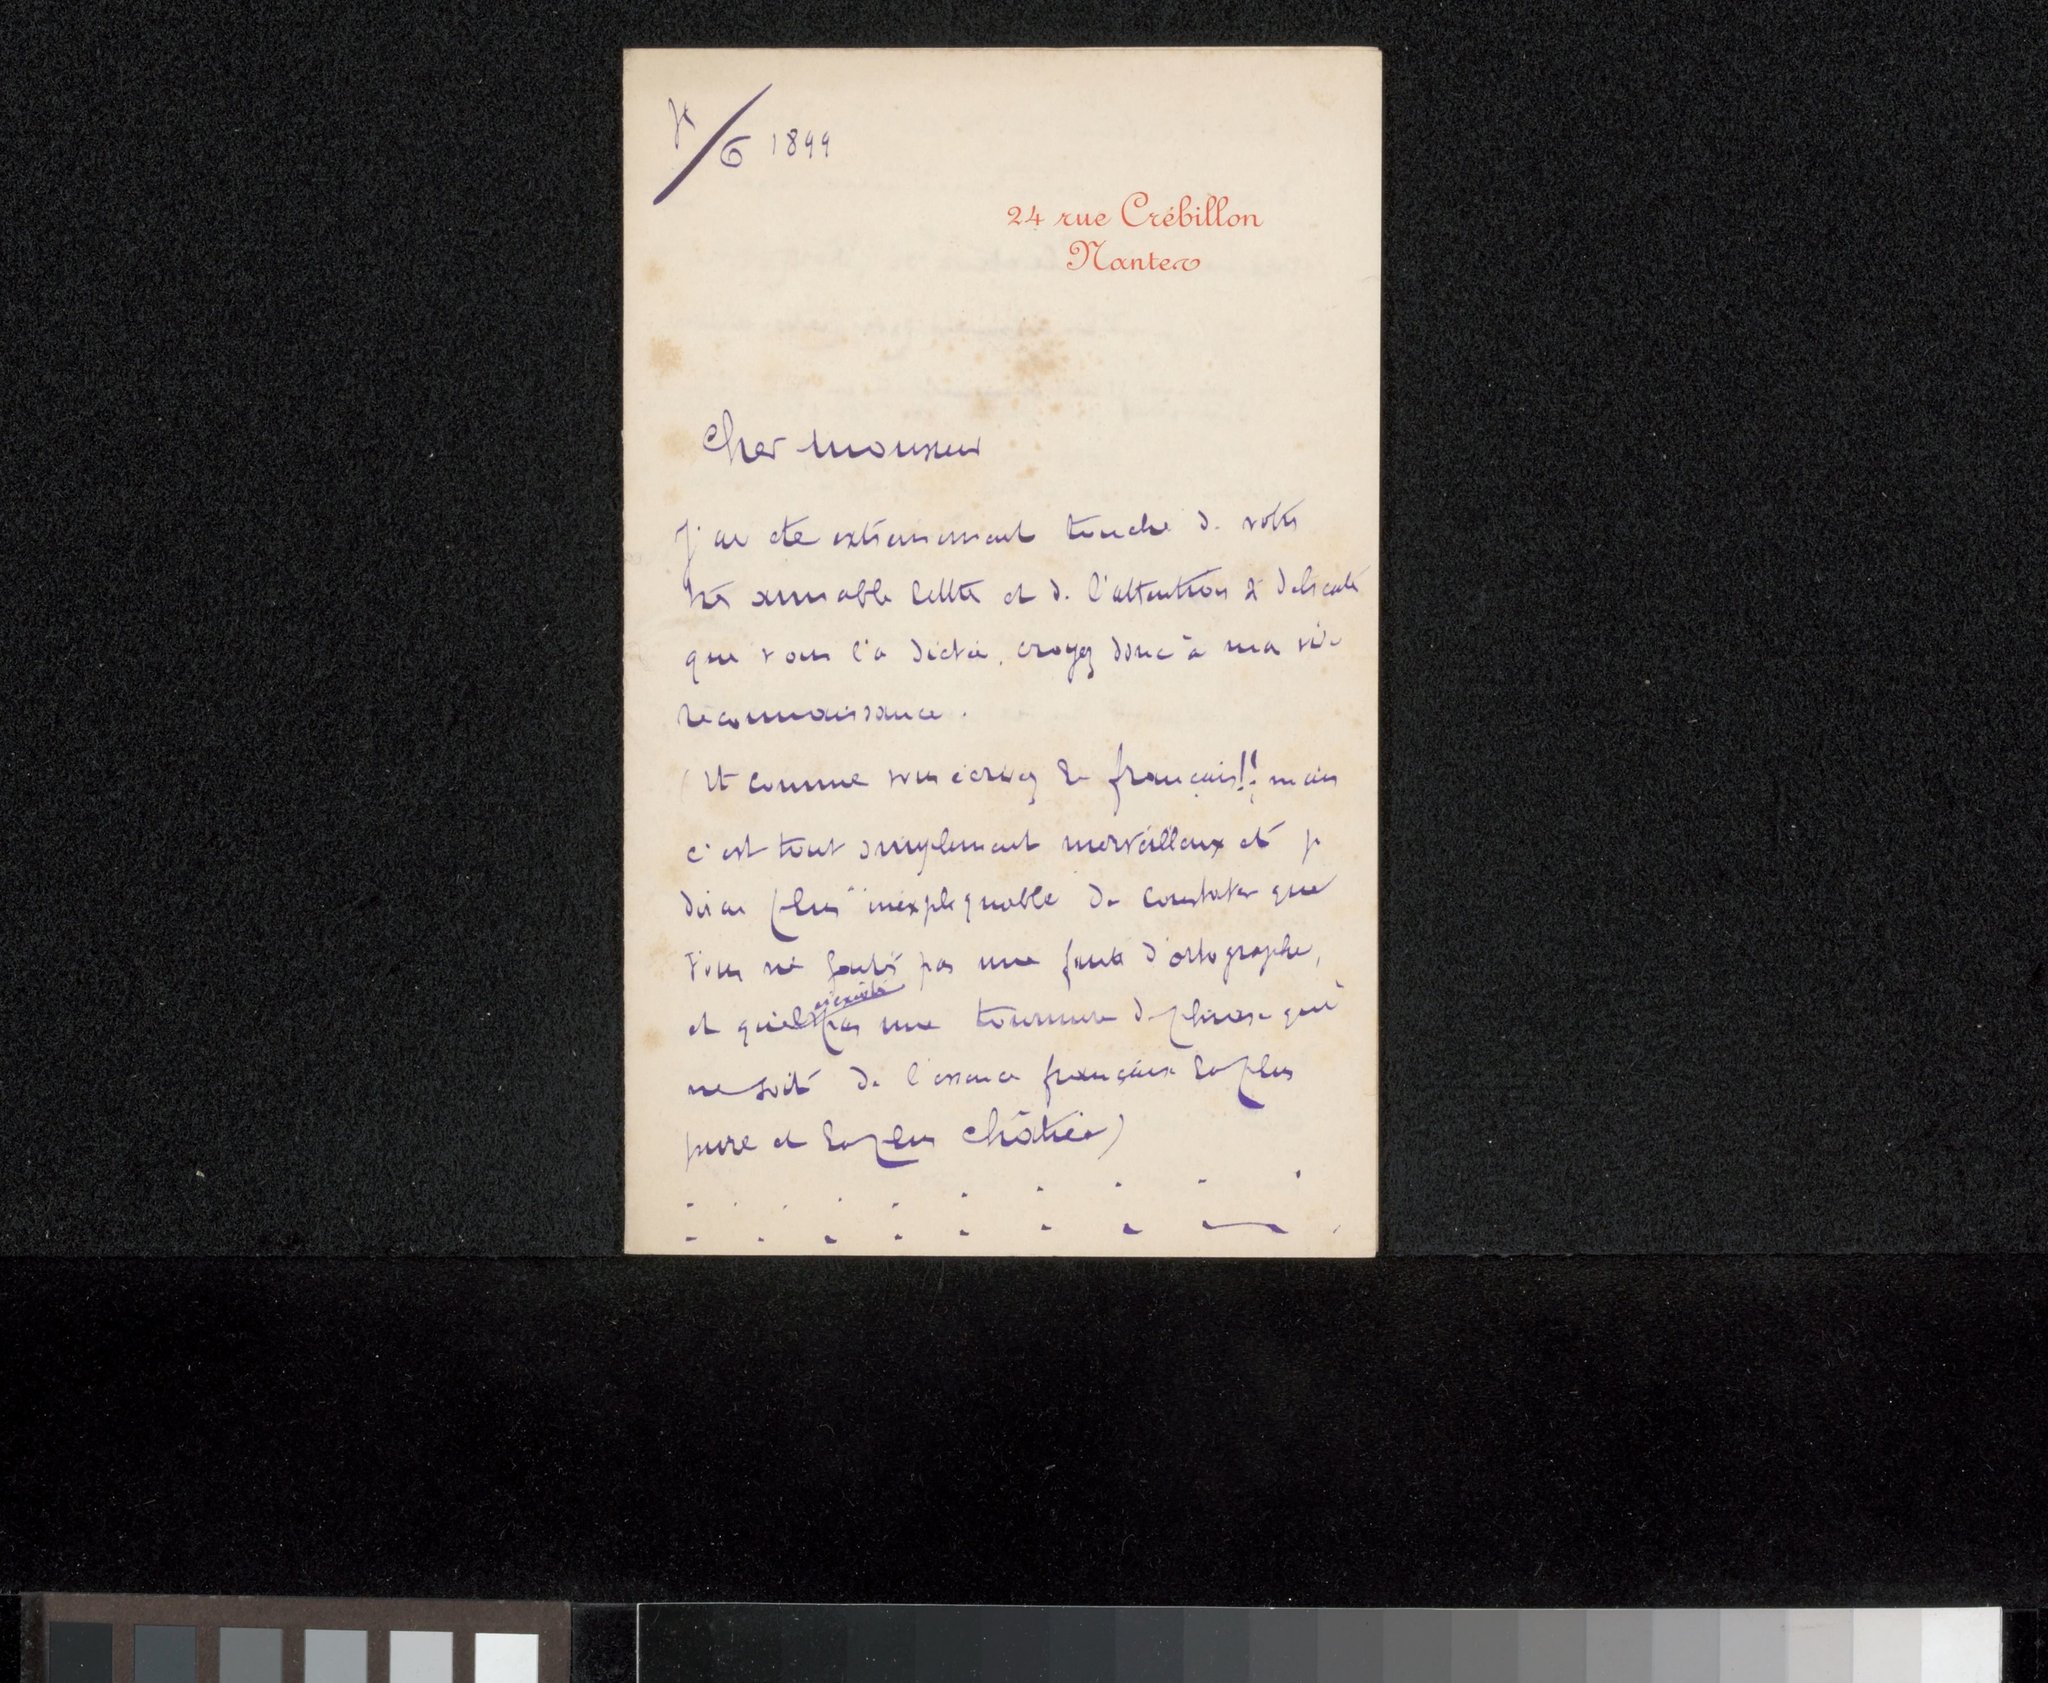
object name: letter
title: Brief aan Philip Zilcken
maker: gustave bourcard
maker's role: verzamelaar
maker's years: 1846-1925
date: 1899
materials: ink, paper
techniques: pen, writing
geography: nantes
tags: félix hilaire buhot, painter, draughtsman, philip zilcken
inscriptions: seal, collector's mark: ‘RPK’